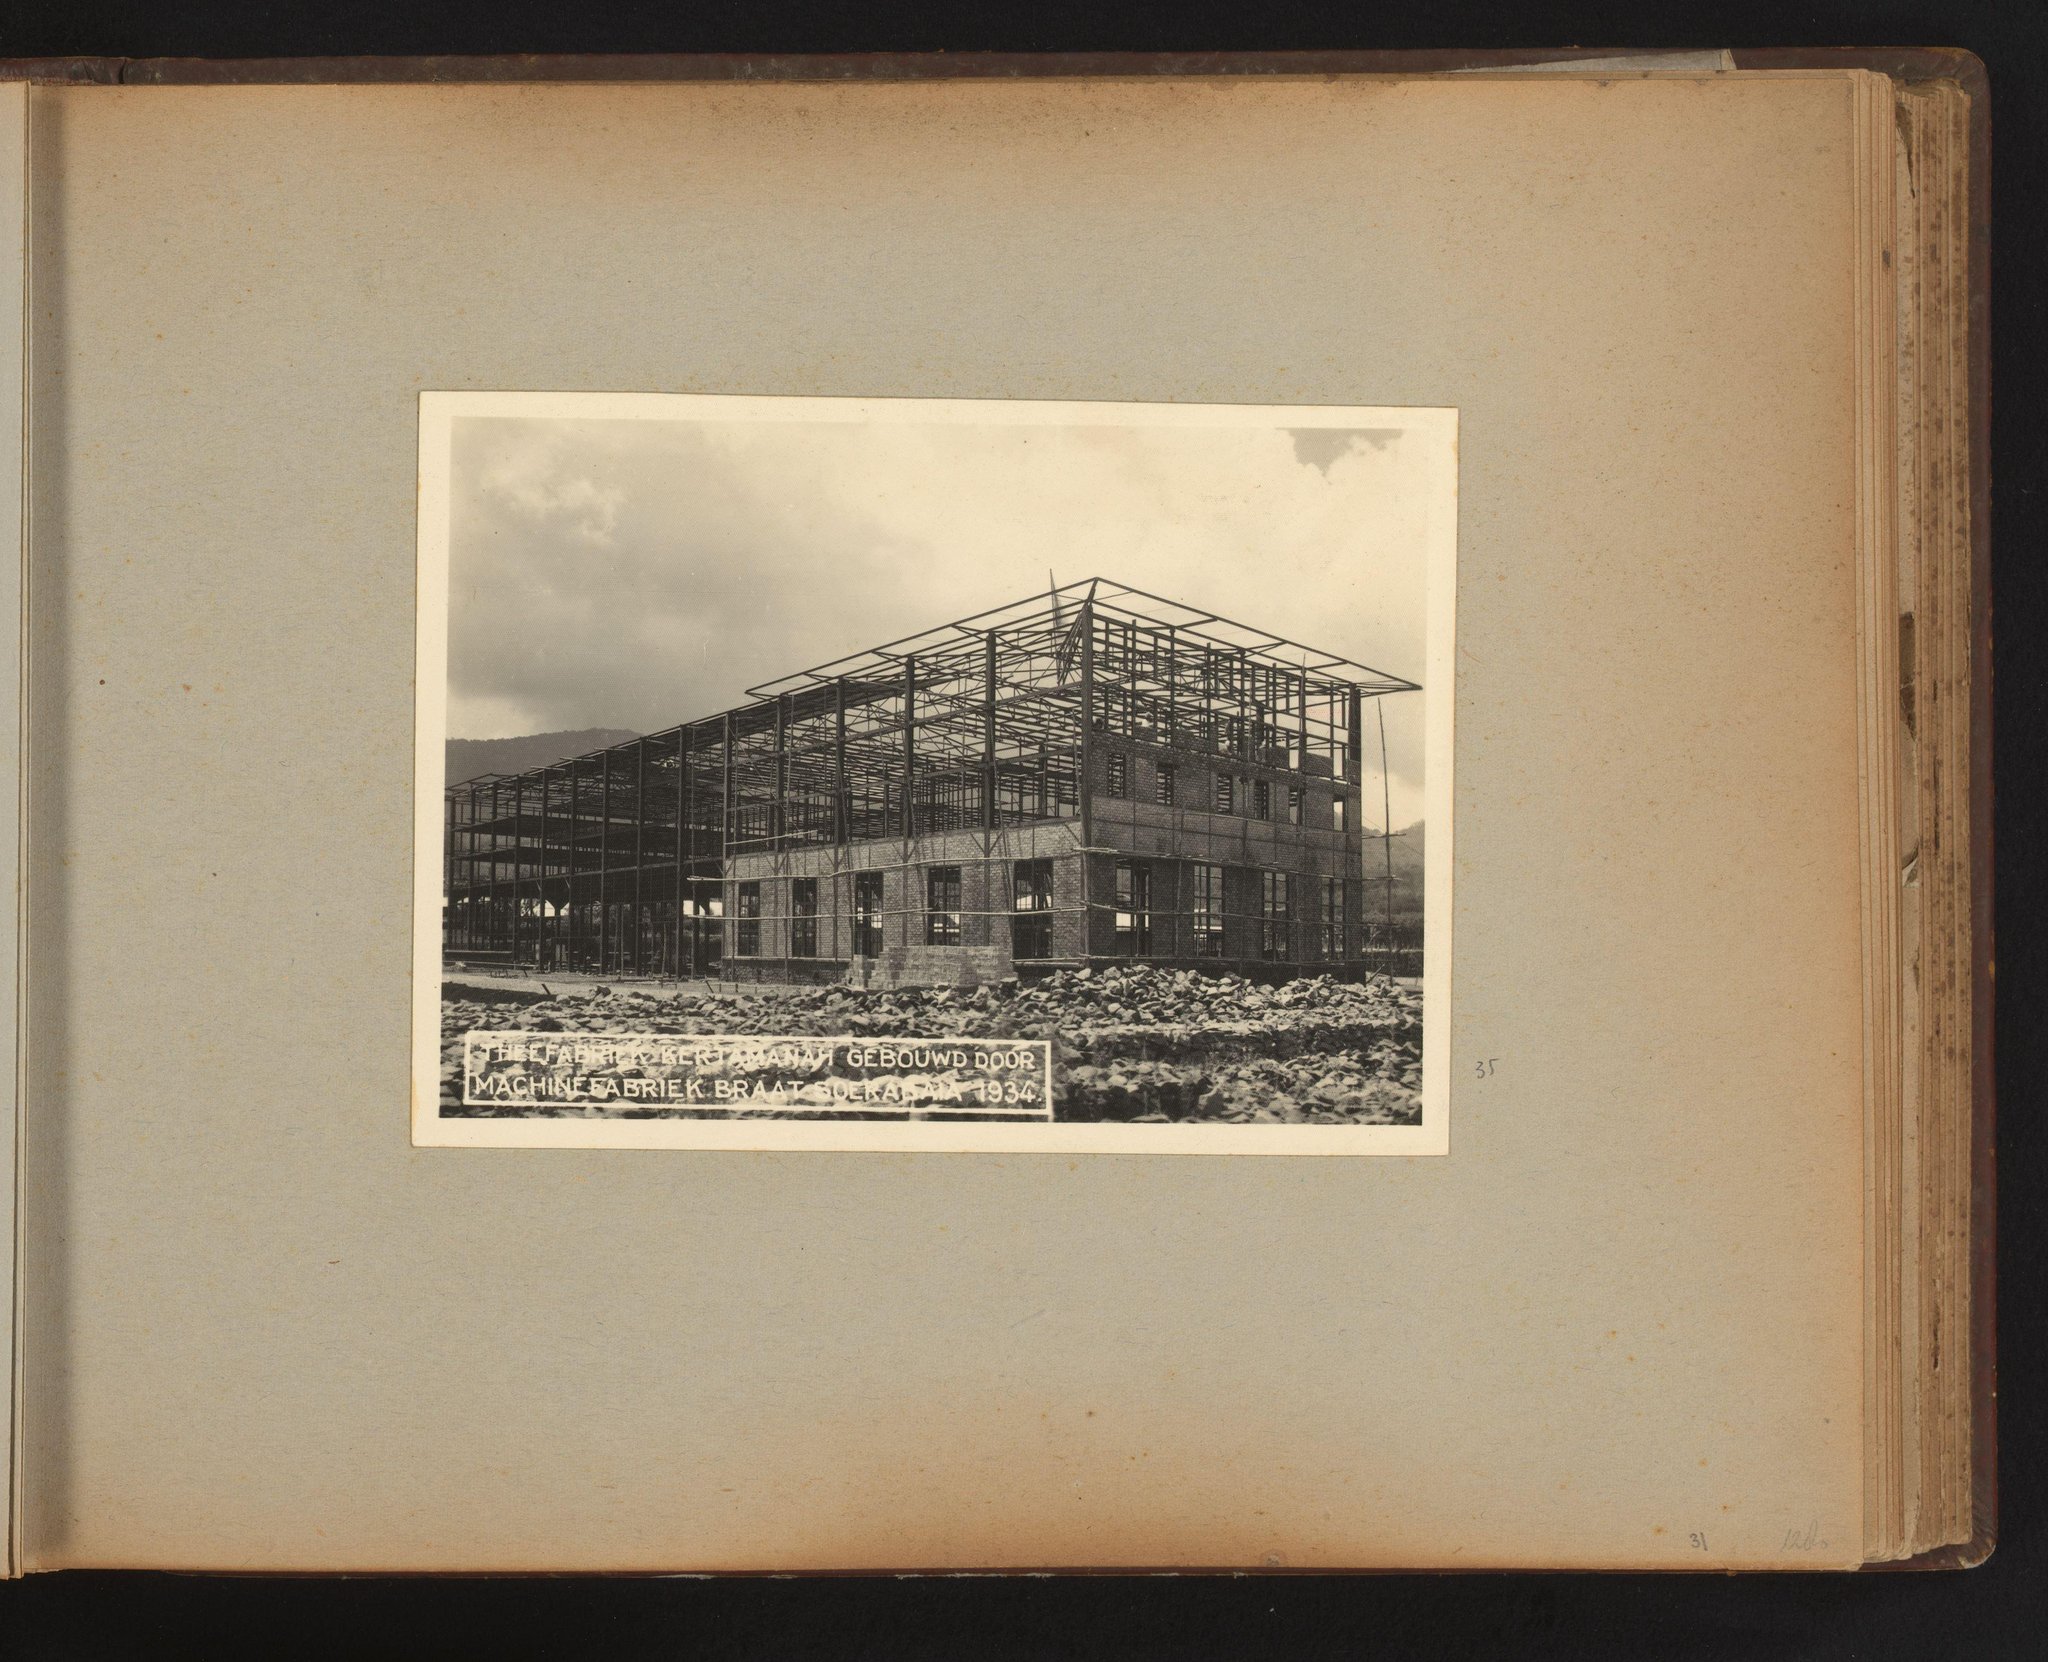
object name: photograph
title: Theefabriek Kertamanah gebouwd door Machinefabriek Braat Soerabaia 1934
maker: d.h. buys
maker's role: fotograaf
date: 1934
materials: cardboard, photographic support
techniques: gelatin silver print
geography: bandung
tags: factory-building, making the overground structures (~ building activities), java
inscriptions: name: ‘D.H. Buys Bandoeng’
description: De theefabriek Kertamanah ten zuiden van Bandoeng, in aanbouw in 1934. Onderdeel van een fotoalbum met foto's van machines en constructies van de N.V. Machinefabriek Braat te Soerabaja, Soekaboemi en Tegal uit de periode 1931-1937.